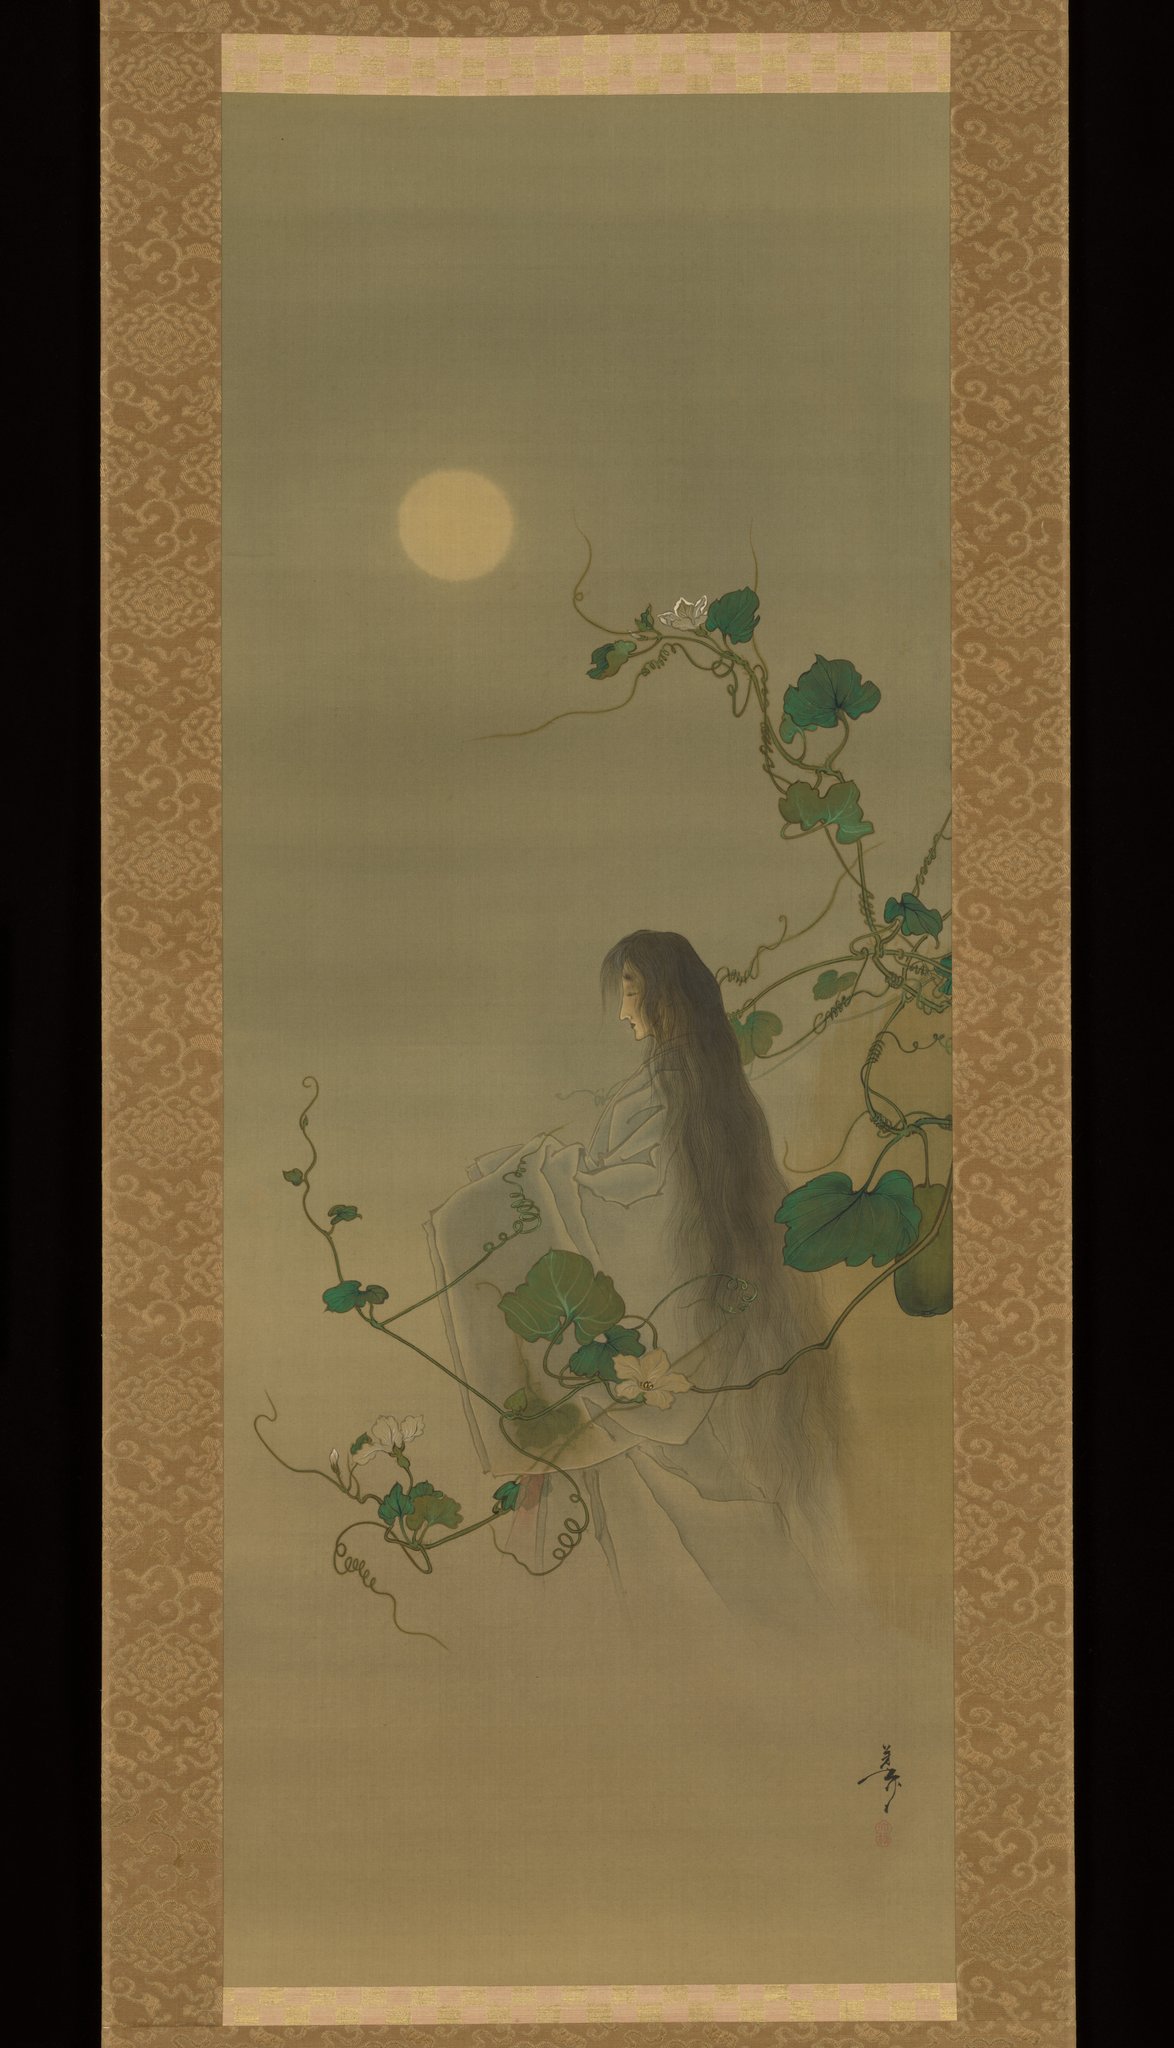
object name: hanging scroll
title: The Spirit of the Deceased Yūgao Entwined in Moonflower Vines, based on the print “The Lady of the Evening Faces,” from the series One Hundred Aspects of the Moon (Tsuki hyakushi: Genji Yūgao no maki)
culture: japanese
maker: tsukioka yoshitoshi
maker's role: artist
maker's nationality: japanese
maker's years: 1839-1892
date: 1892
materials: ink, silk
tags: women